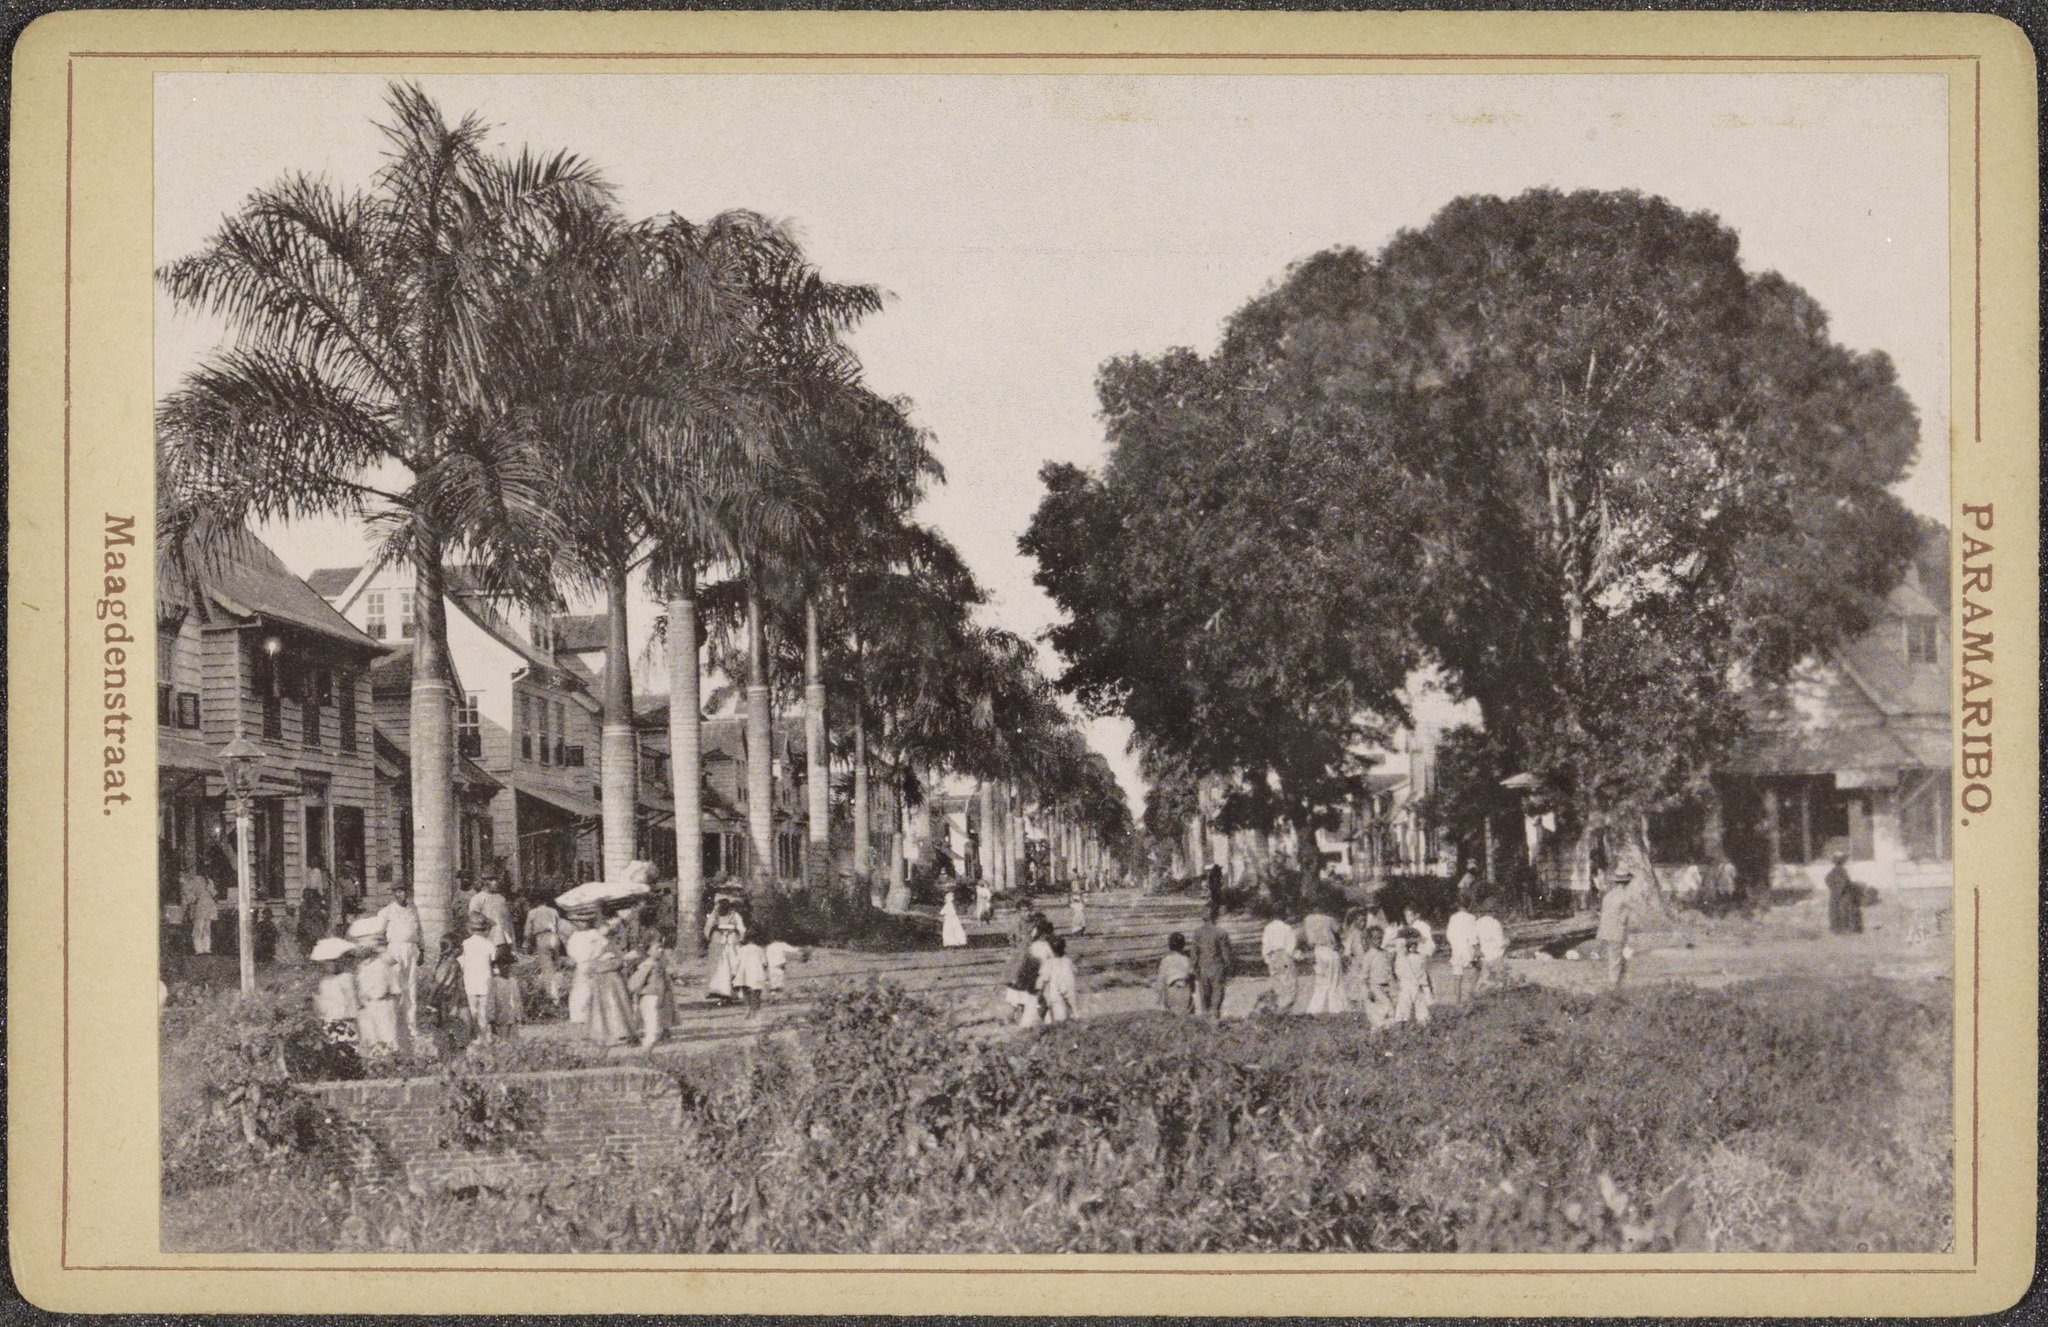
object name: photograph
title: Maagdenstraat in Paramaribo met bomen en voorbijgangers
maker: eugen klein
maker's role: fotograaf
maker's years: 1869-1927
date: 1900-1927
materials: cardboard, paper, ink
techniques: photograph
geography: paramaribo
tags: strolling, travelling; tourism, trees: palm-tree, prospect of city, town panorama, silhouette of city, street (+ city(-scape) with figures, staffage), suriname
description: Onderdeel van Fotoalbum met bezienswaardigheden in Paramaribo.